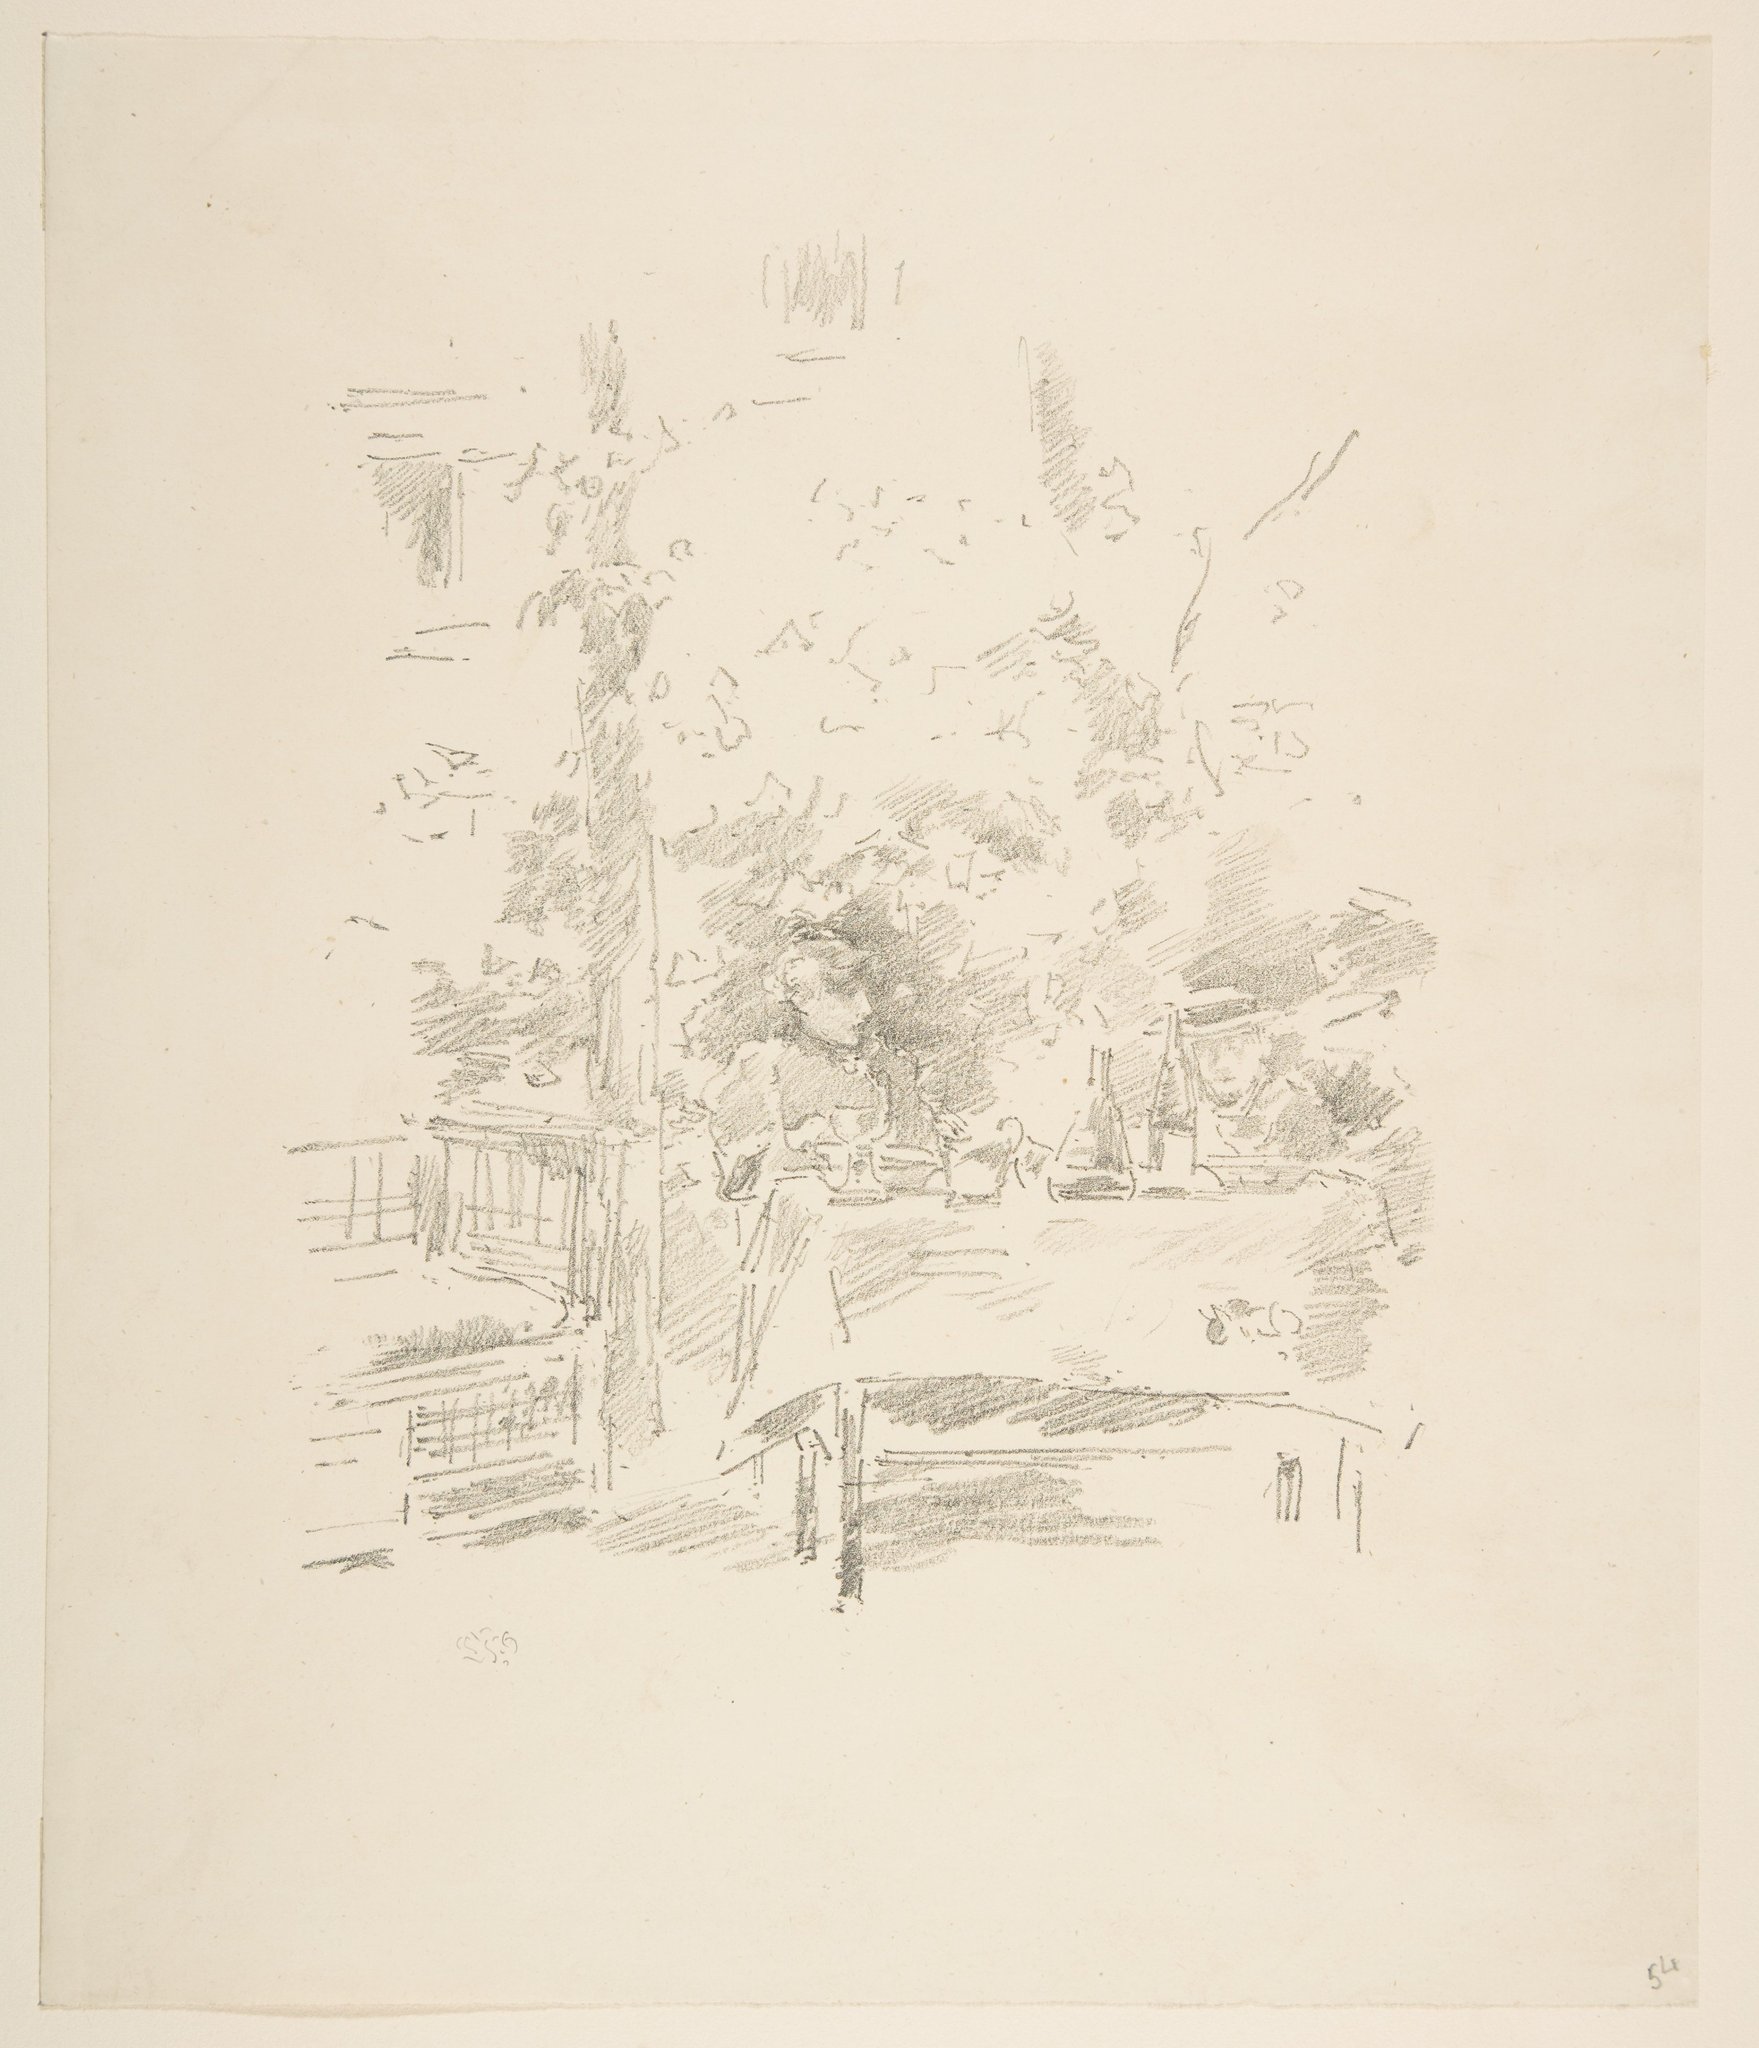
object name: print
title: Tête-à-tête in the Garden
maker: james mcneill whistler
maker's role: artist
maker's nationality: american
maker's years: 1834-1903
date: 1894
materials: ink, paper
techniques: printing, lithography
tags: human figures,gardeners,tables